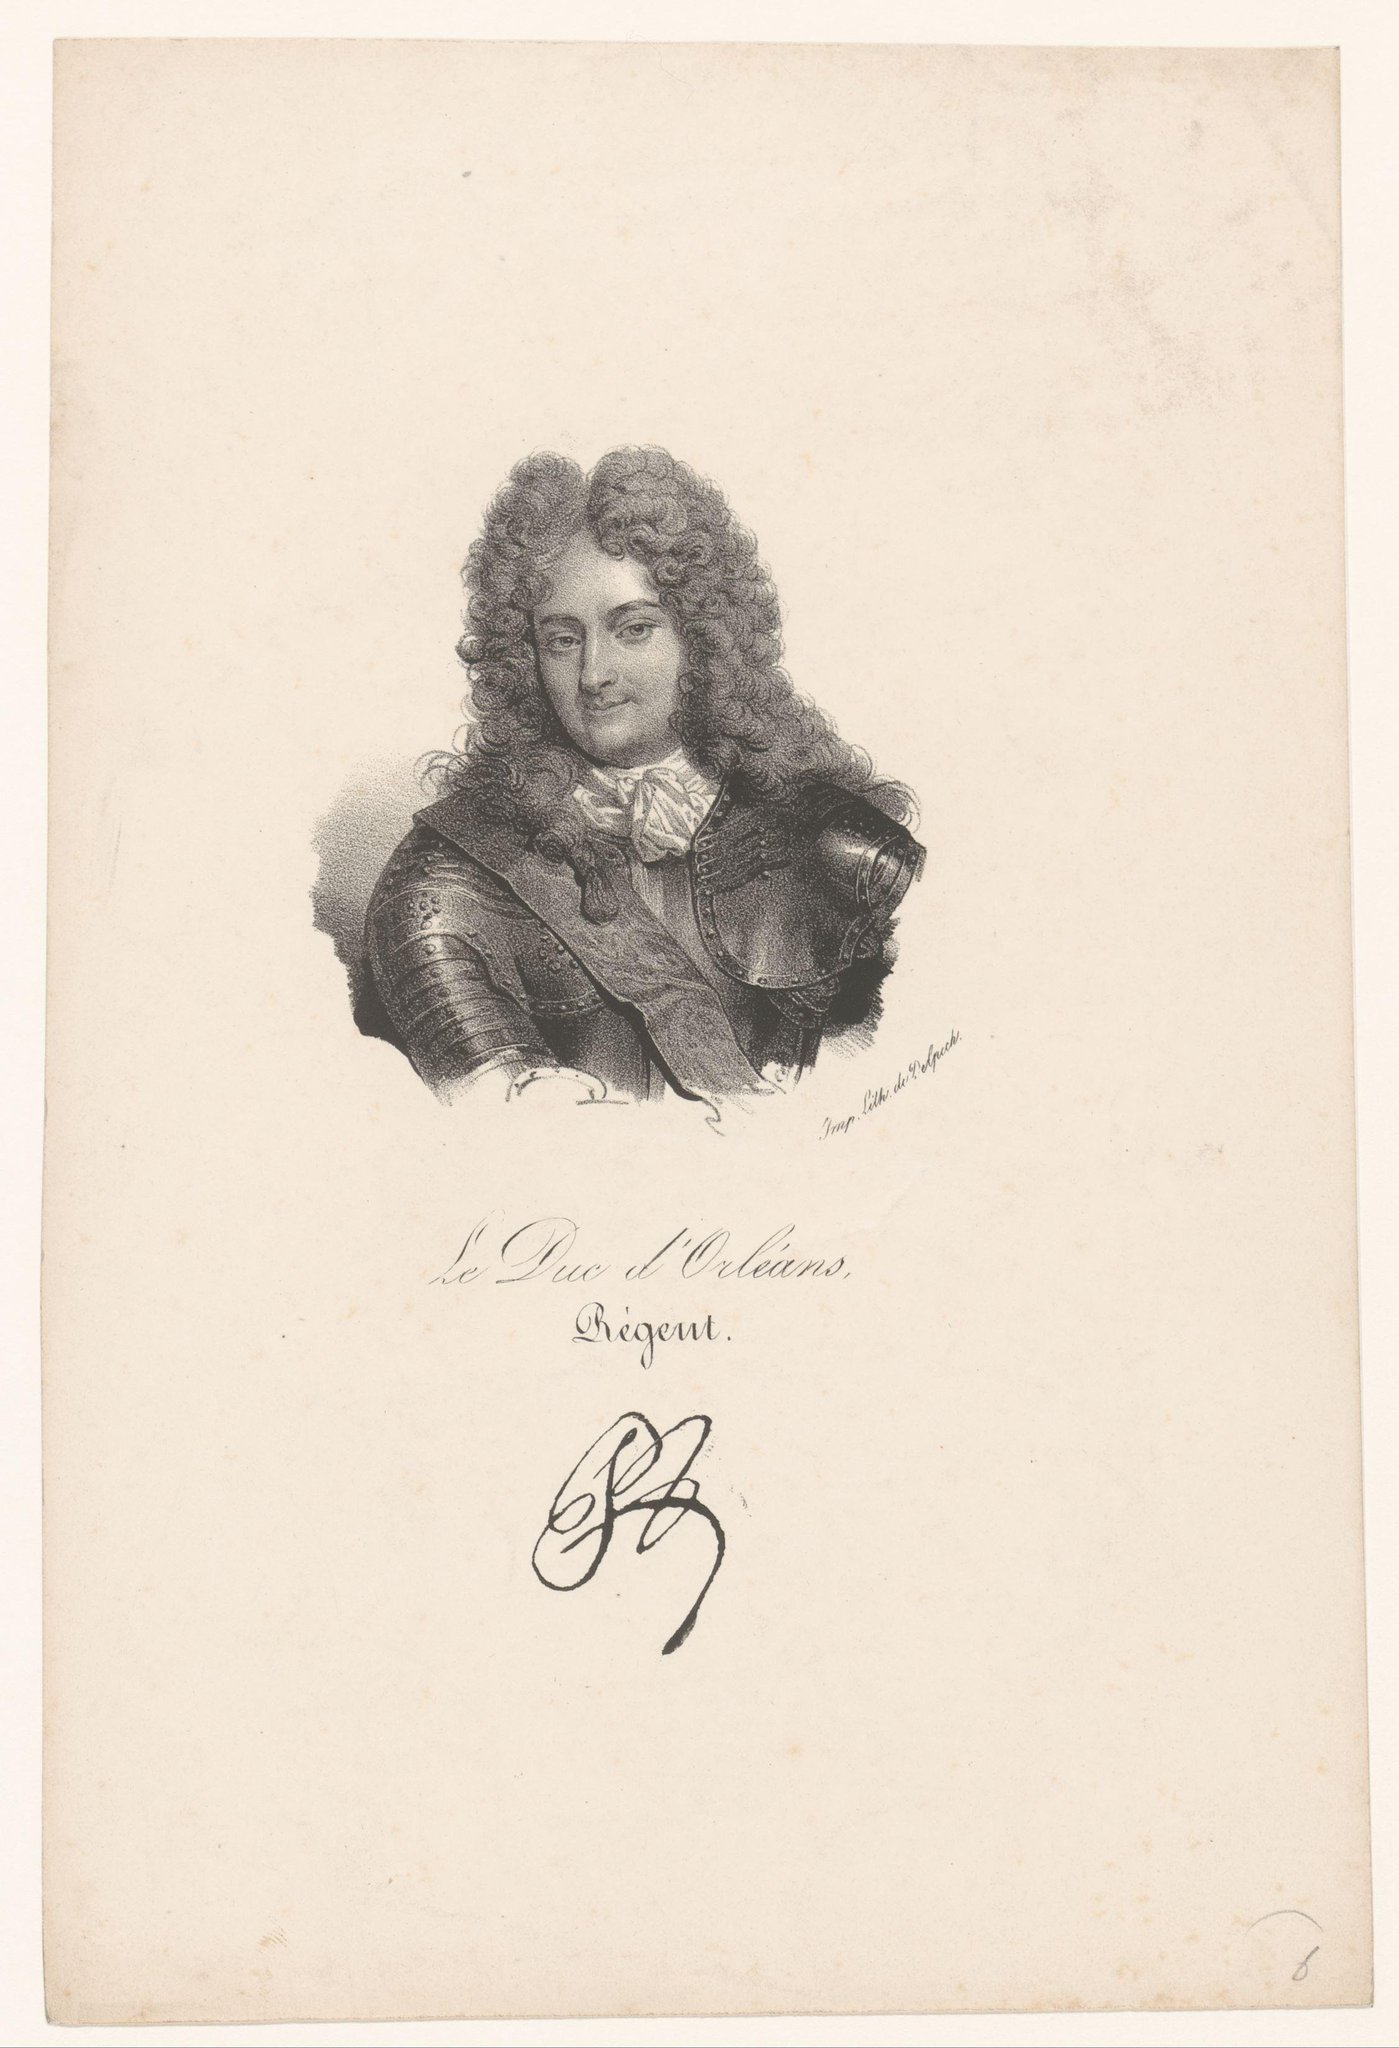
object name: print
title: Le Duc d'Oréans, Régent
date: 1818-1842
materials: paper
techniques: lithograph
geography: paris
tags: filips ii (hertog van orléans), historical persons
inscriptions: collector's mark: Lugt 2228a